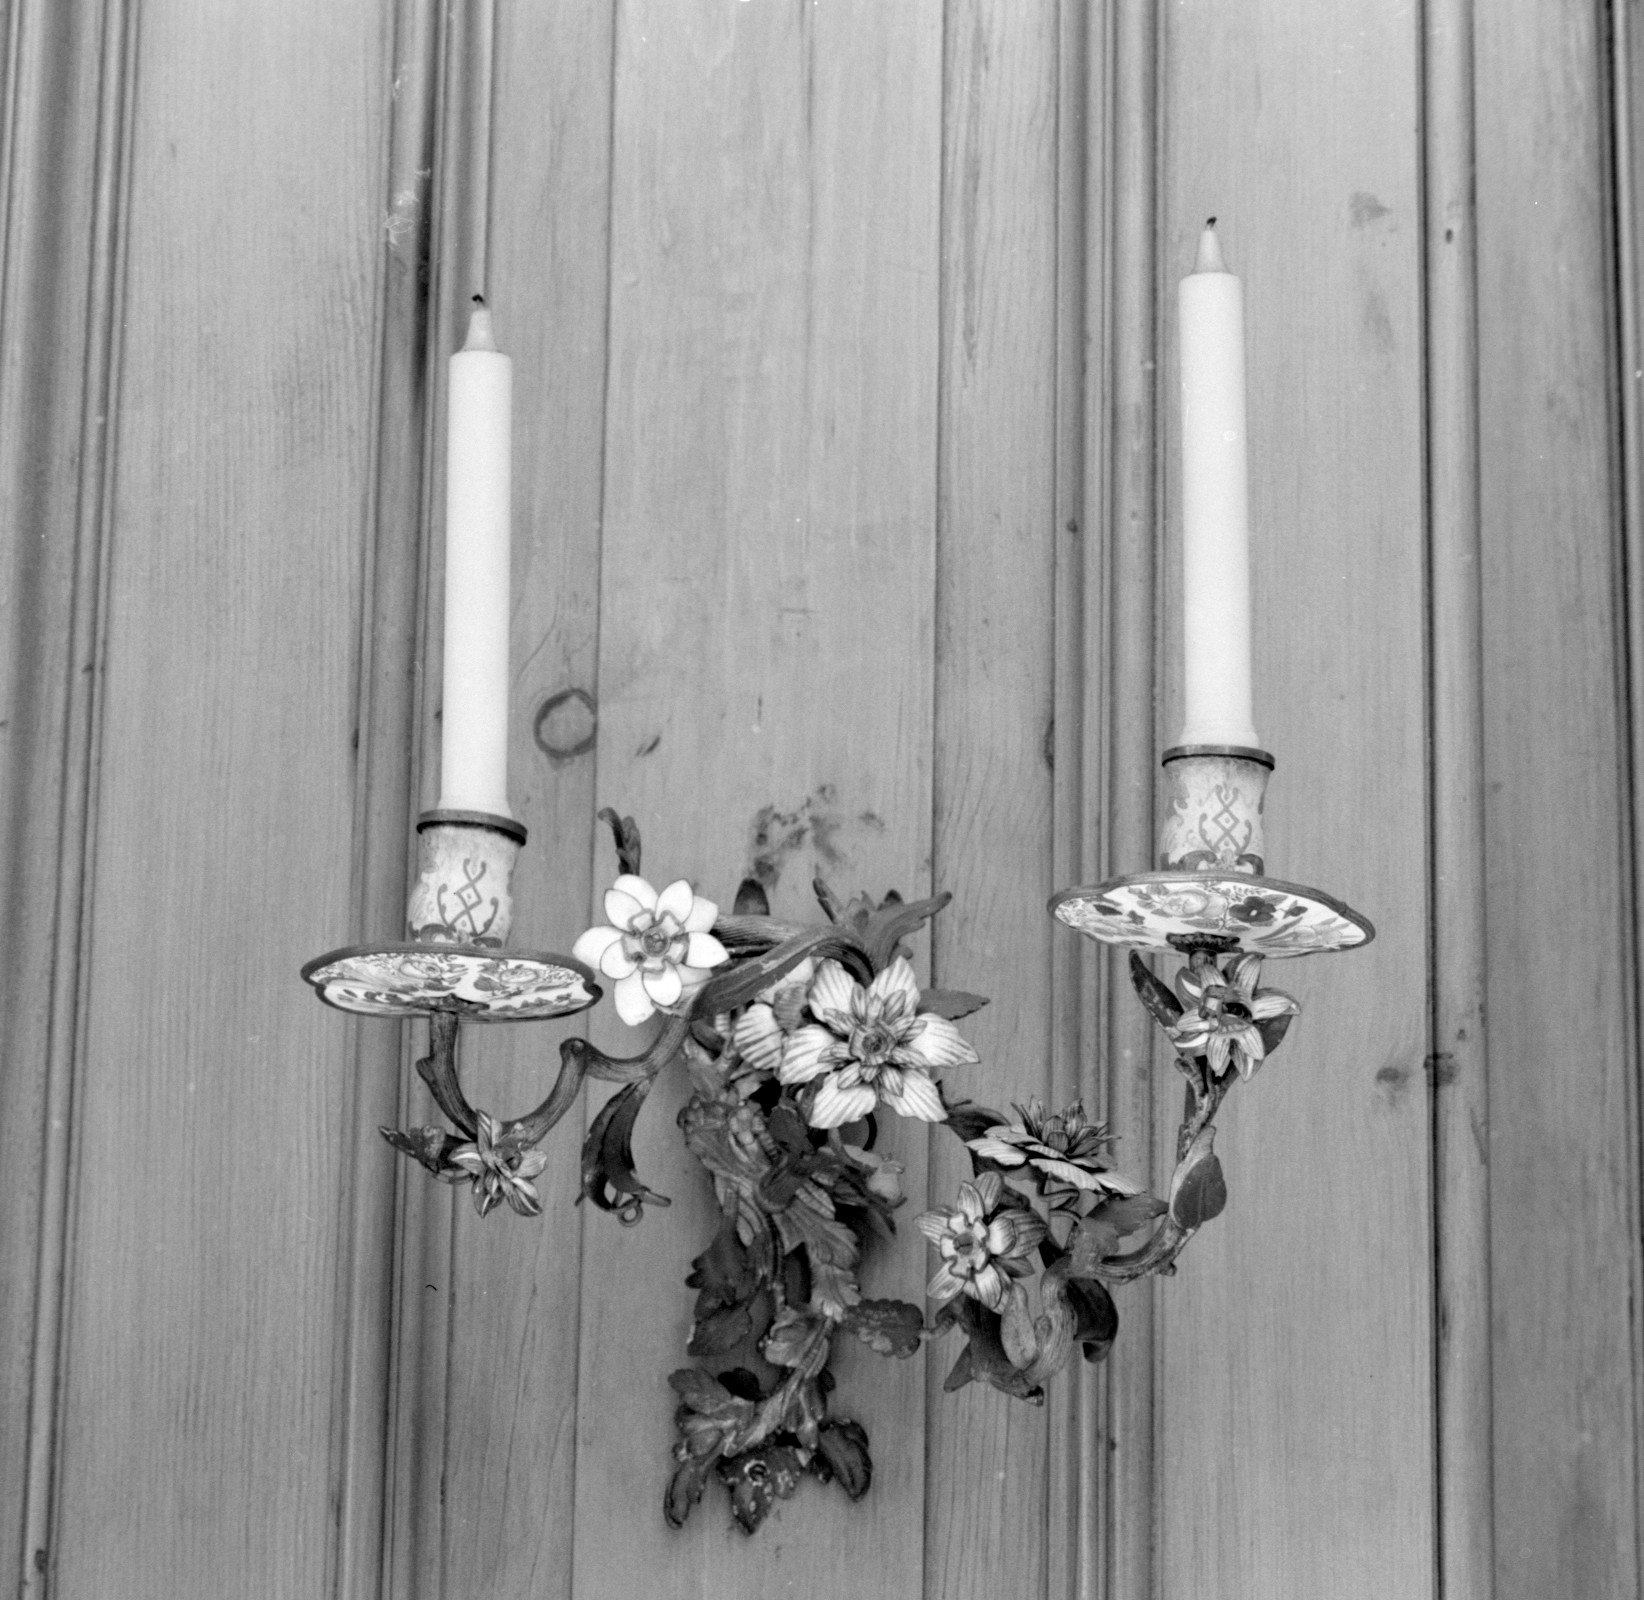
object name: wall bracket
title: Pair of two-light wall brackets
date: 1740-1750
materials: bronze, enamel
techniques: gilding, painting